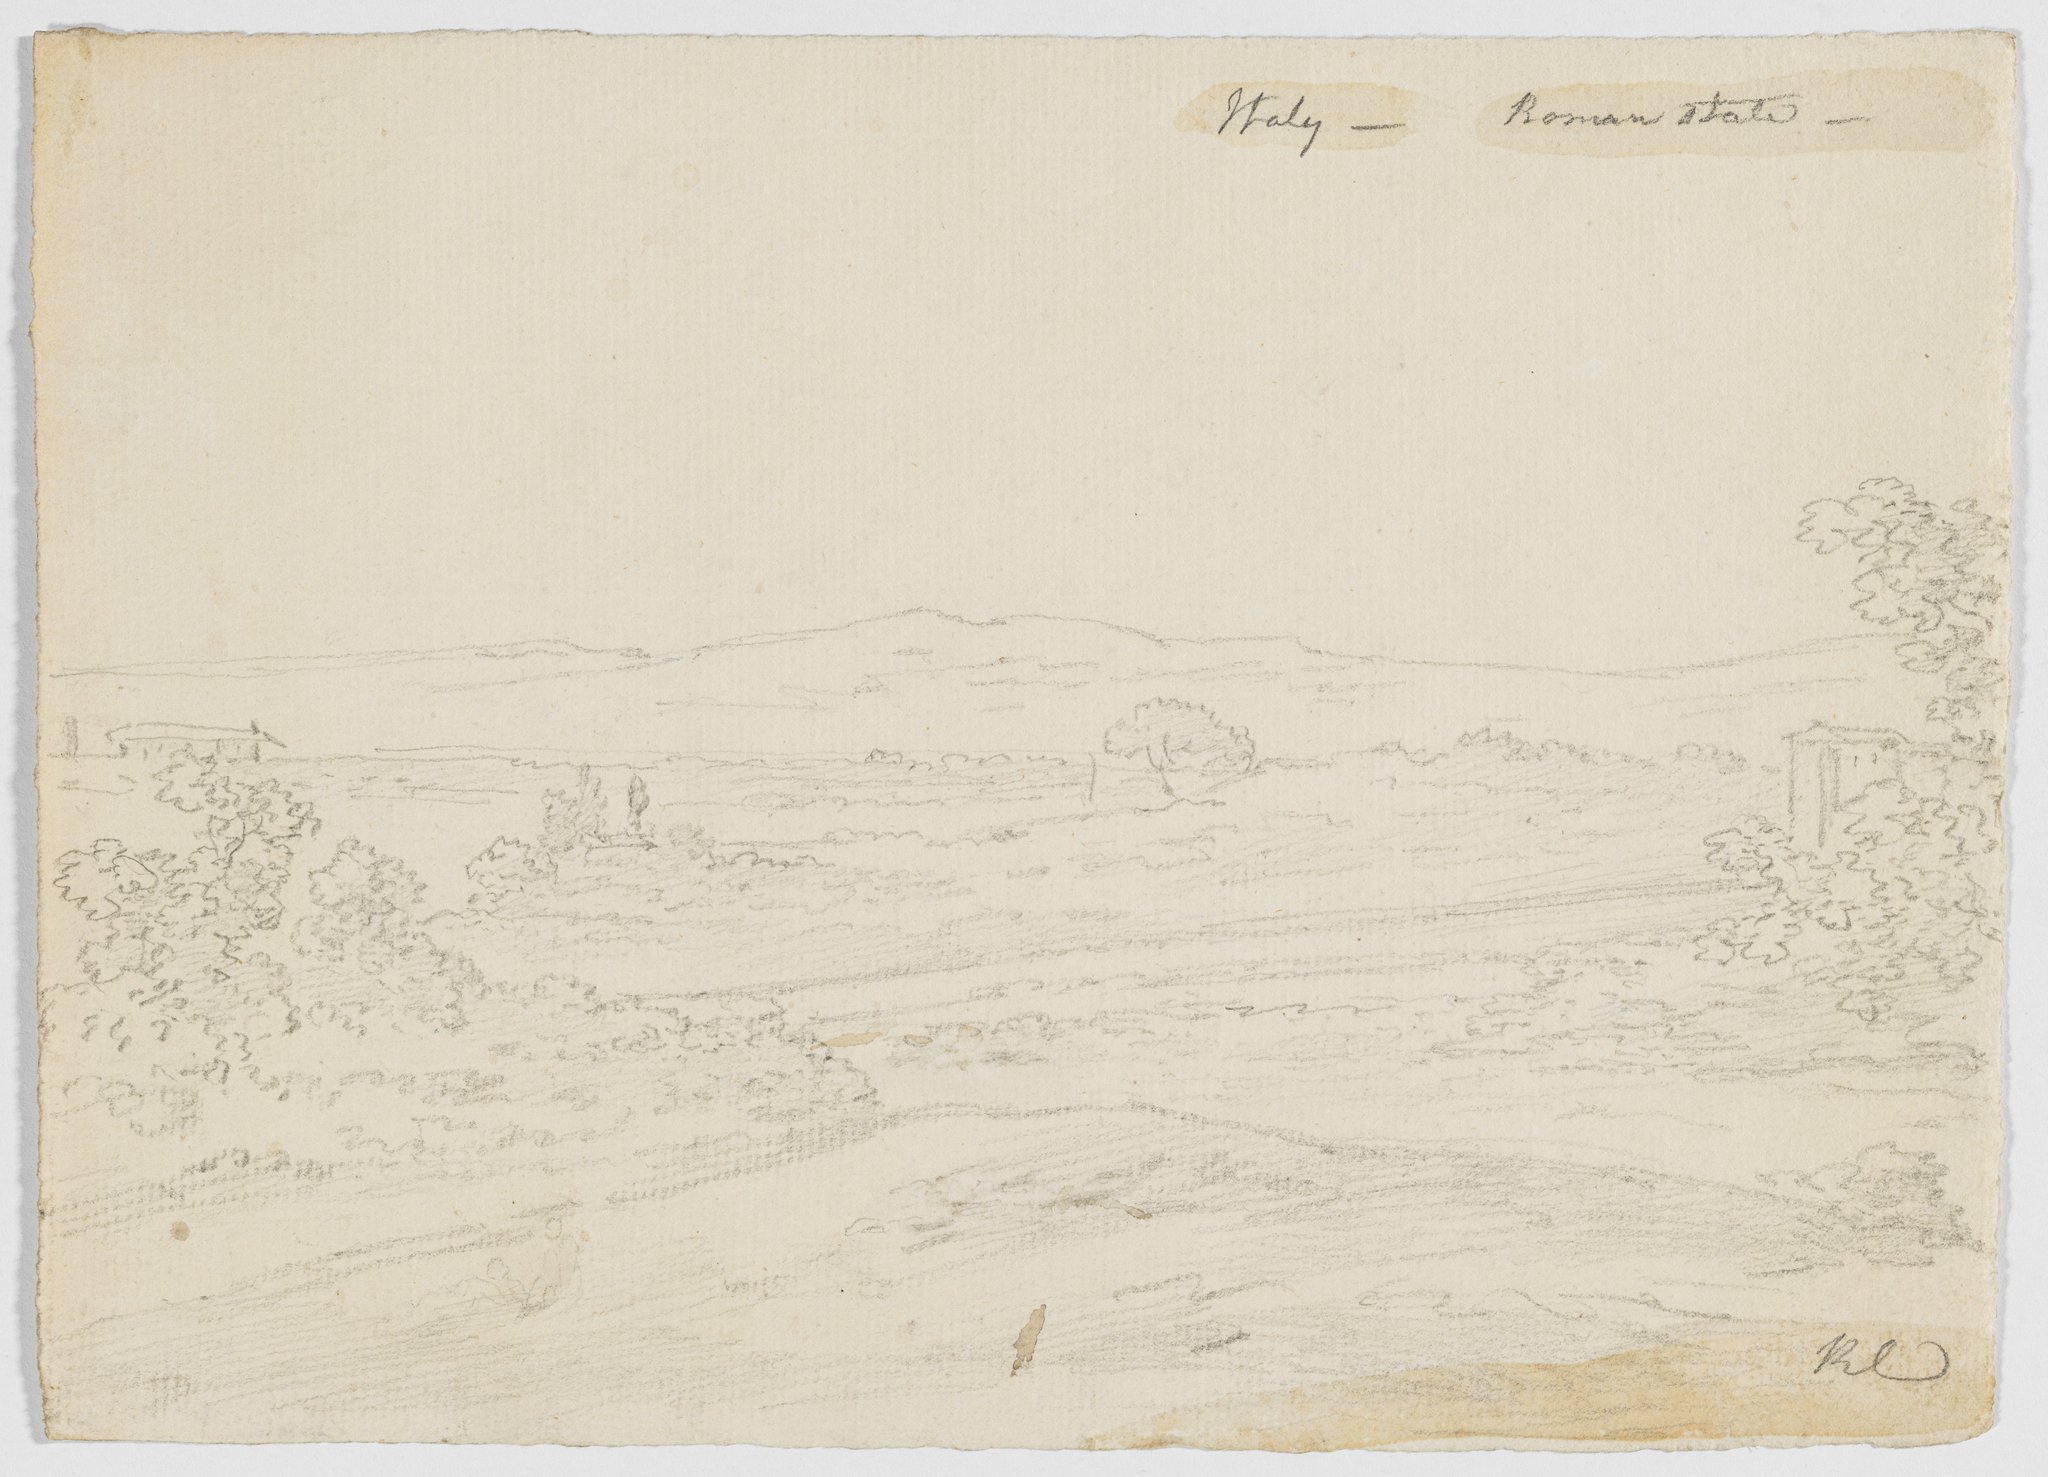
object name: drawing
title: Italy, Roman State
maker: richard cooper ii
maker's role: artist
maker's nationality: british, scottish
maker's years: 1740-1822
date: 1774-1775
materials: graphite